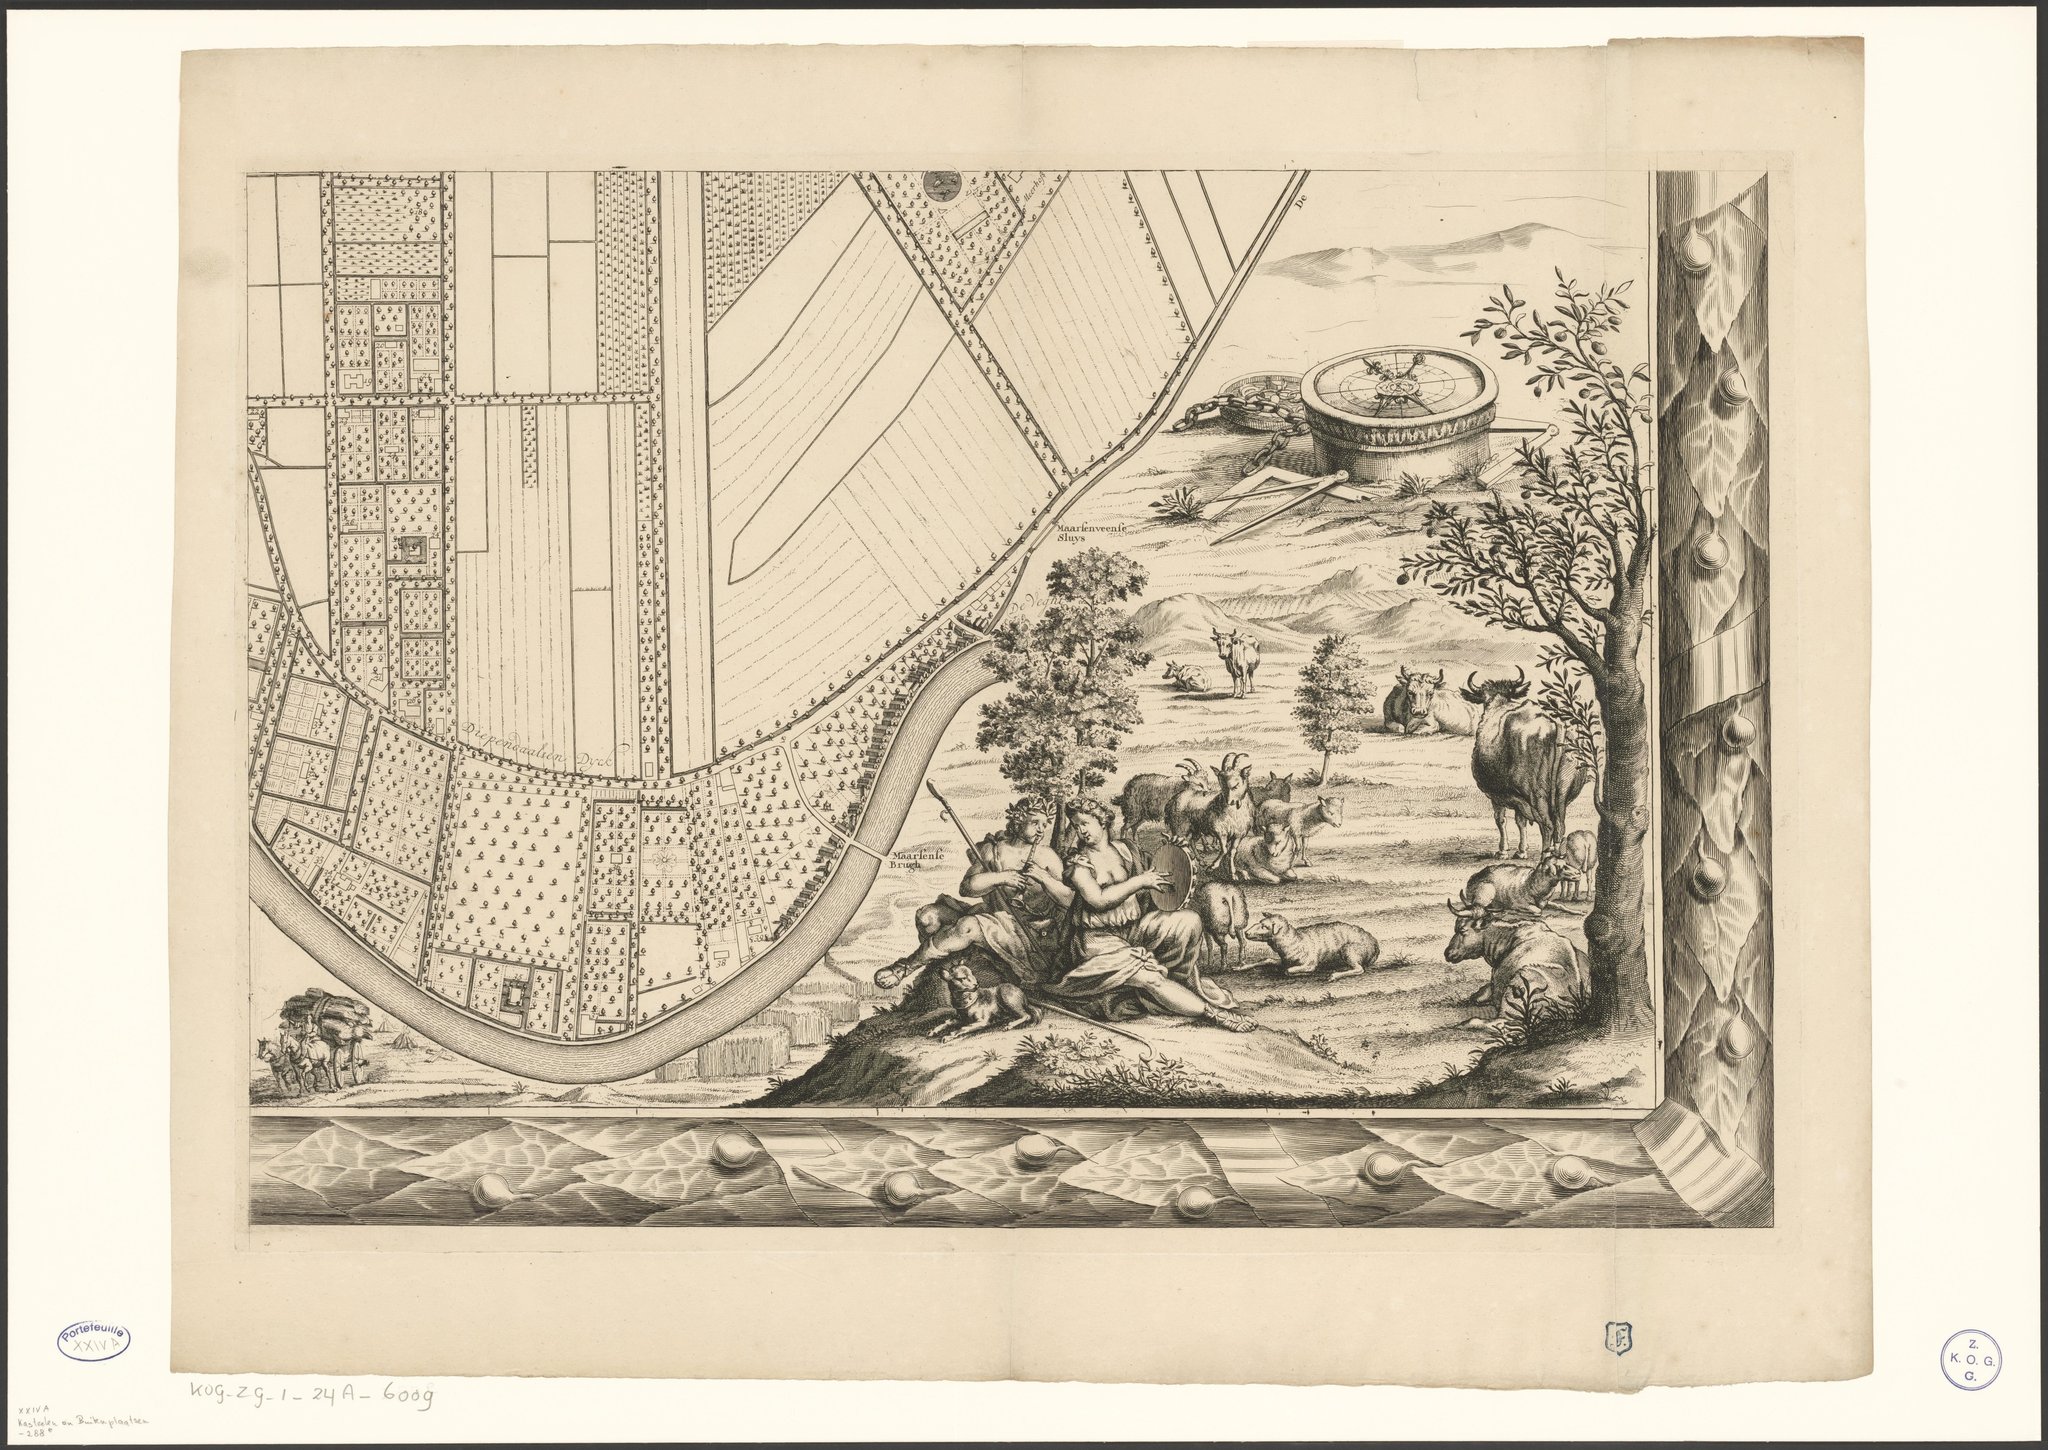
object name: print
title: Plattegrond van de heerlijkheid Maarsseveen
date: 1690-1691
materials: paper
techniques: engraving, etching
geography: netherlands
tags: herding, herdsman, herdswoman, shepherd, shepherdess, cowherd, etc., compasses, maps of cities, compass, pastorals, arcadian scenes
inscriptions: collector's mark: Lugt 1641, collector's mark: Lugt 963, collector's mark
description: Plaat rechtsonder. De plattegrond van een gedeelte van de heerlijkheid Maarsseveen. Onderaan afbeeldingen van een arcadisch landschap met herders, een kompas, passer en andere meetinstrumenten. Onderwerpsrubrieken binnen de Atlas Zeden en Gewoonten: Kastelen en buitenplaatsen; prenten van bijzonder groot formaat.